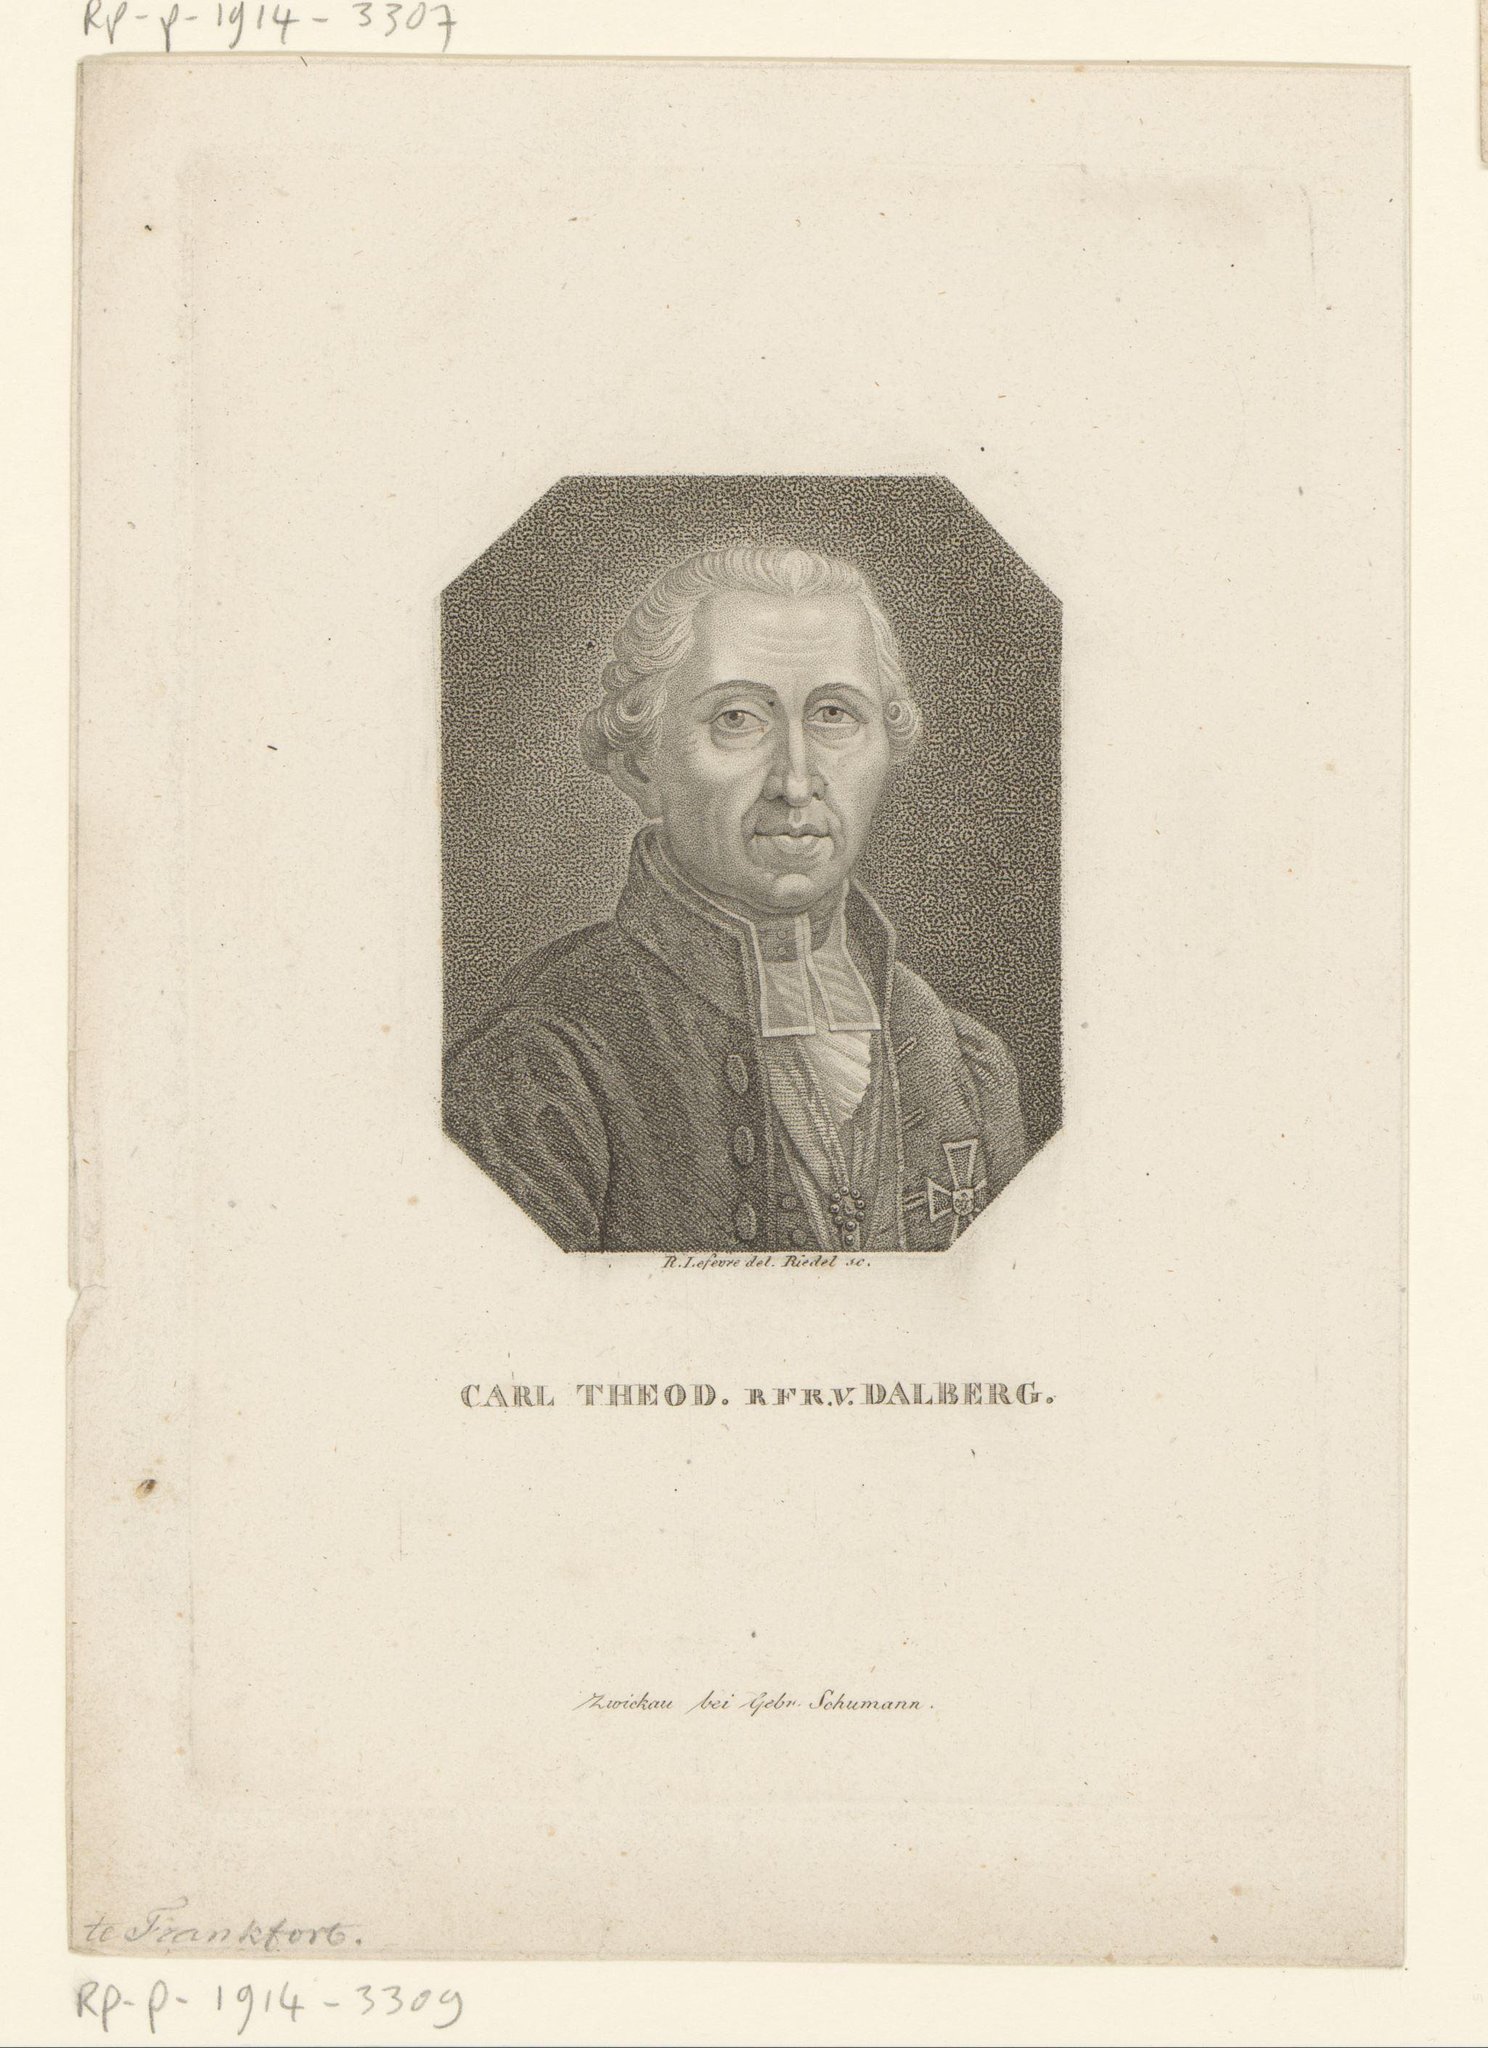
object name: print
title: Portret van Carl Theodor Anton Maria von Dalberg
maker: karl traugott riedel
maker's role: print maker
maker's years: 1769-1832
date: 1779-1850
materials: paper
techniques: engraving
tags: priest, karl theodor von dalberg, historical persons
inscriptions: : ‘te Frankfort’, collector's mark: Lugt 2228